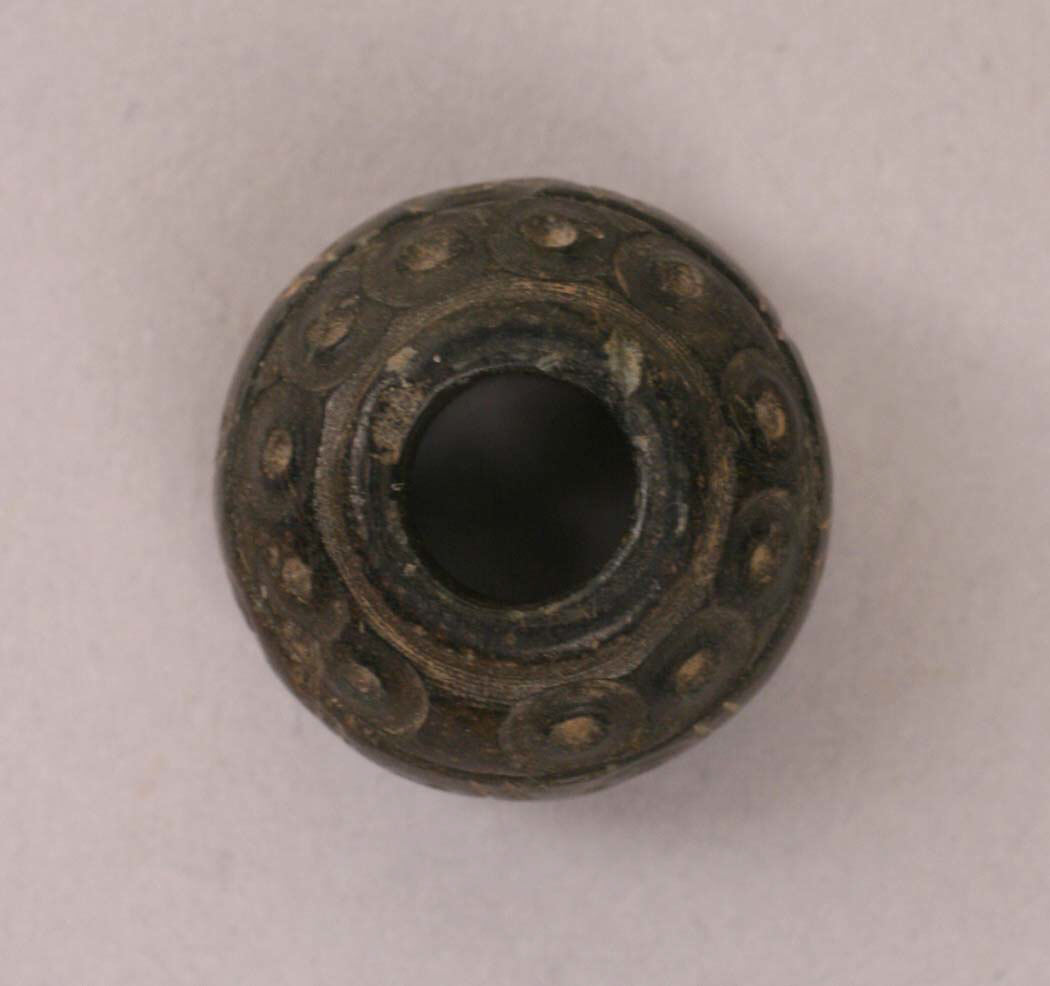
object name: button or bead or spindle whorl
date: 801-1000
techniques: incising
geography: iran